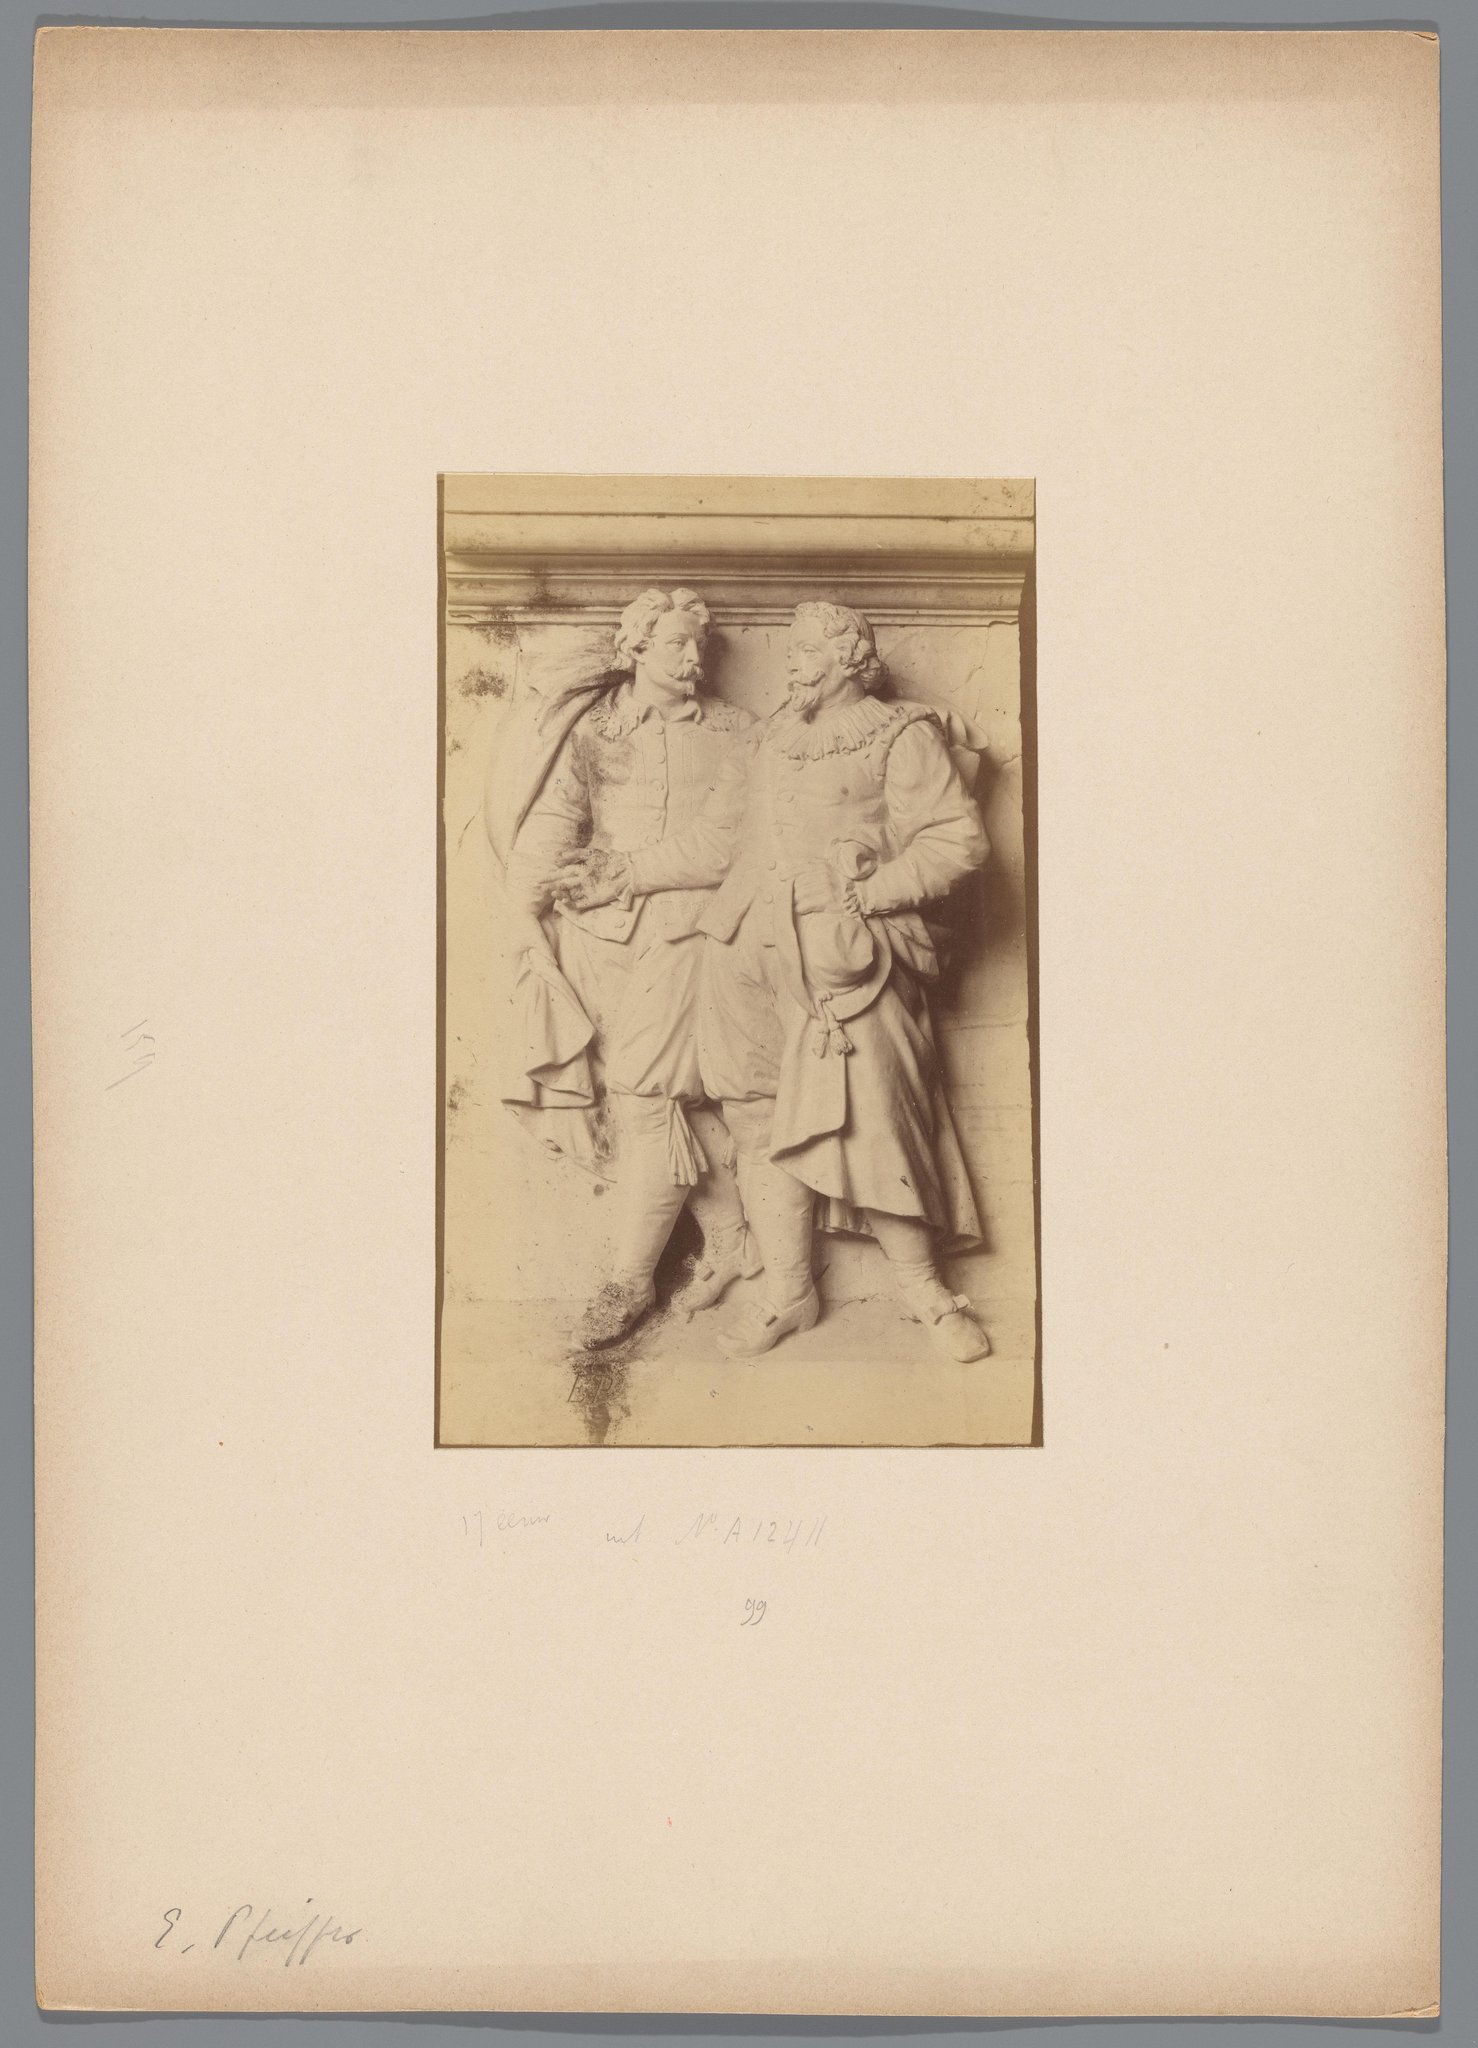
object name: photograph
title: Fotoreproductie van een beeldhouwwerk met twee figuren uit de zeventiende eeuw door Ernst Pfeifer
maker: Anonymous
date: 1880-1887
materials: cardboard, paper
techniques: albumen print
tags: piece of sculpture, reproduction of a piece of sculpture, painter in non-work situation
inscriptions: collector's mark: Lugt 2228, inscription: ‘17 eeuw uit No A12411/ 99/ 159’, inscription: ‘E. Pfeiffer’